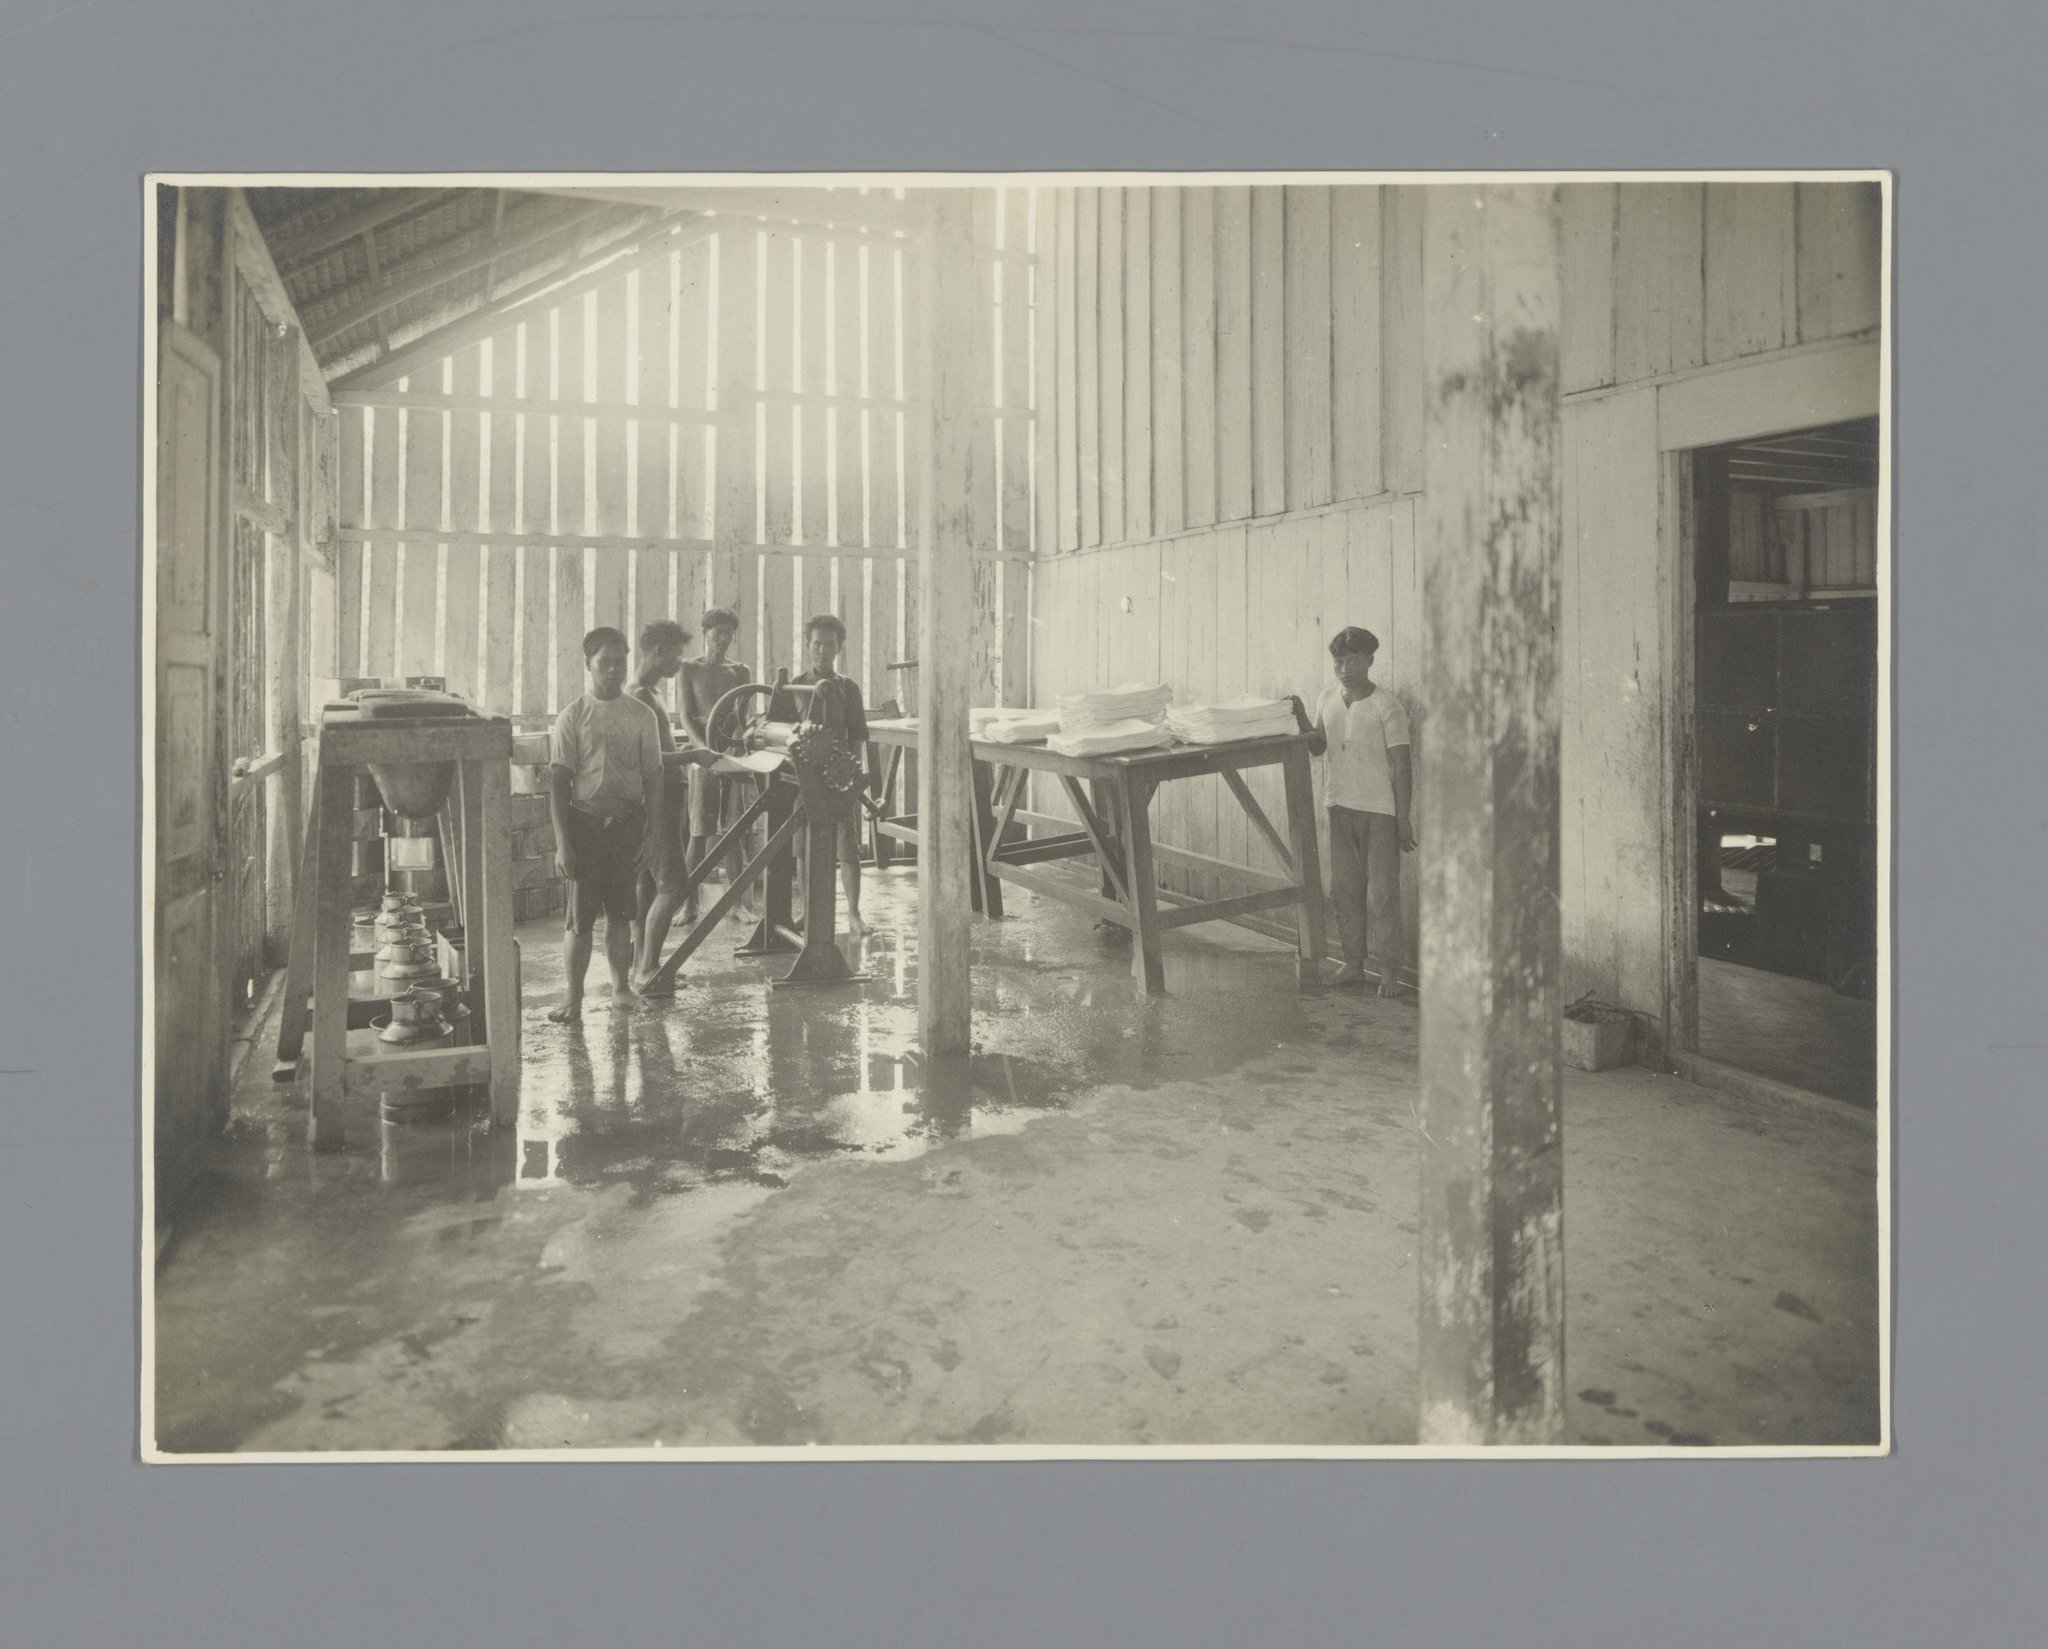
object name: photograph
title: Lokale arbeiders maken rubber op de rubberplantage Boekit Pajong, Sumatra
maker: Anonymous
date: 1910-1920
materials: paper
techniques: gelatin silver print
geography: tandjong poera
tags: plantation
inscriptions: inscription: ‘25./ Rubber coagulieren, Walzen/ in fabrik./ 22./ Latex mit Ameisensäure/ zu Kuchen gerinnen lassen,/ dann walzen u. räuchern,/ Man bekommt dann Crep-/ rubber/ Tandjong-Poera,/ Boekit Payong.’